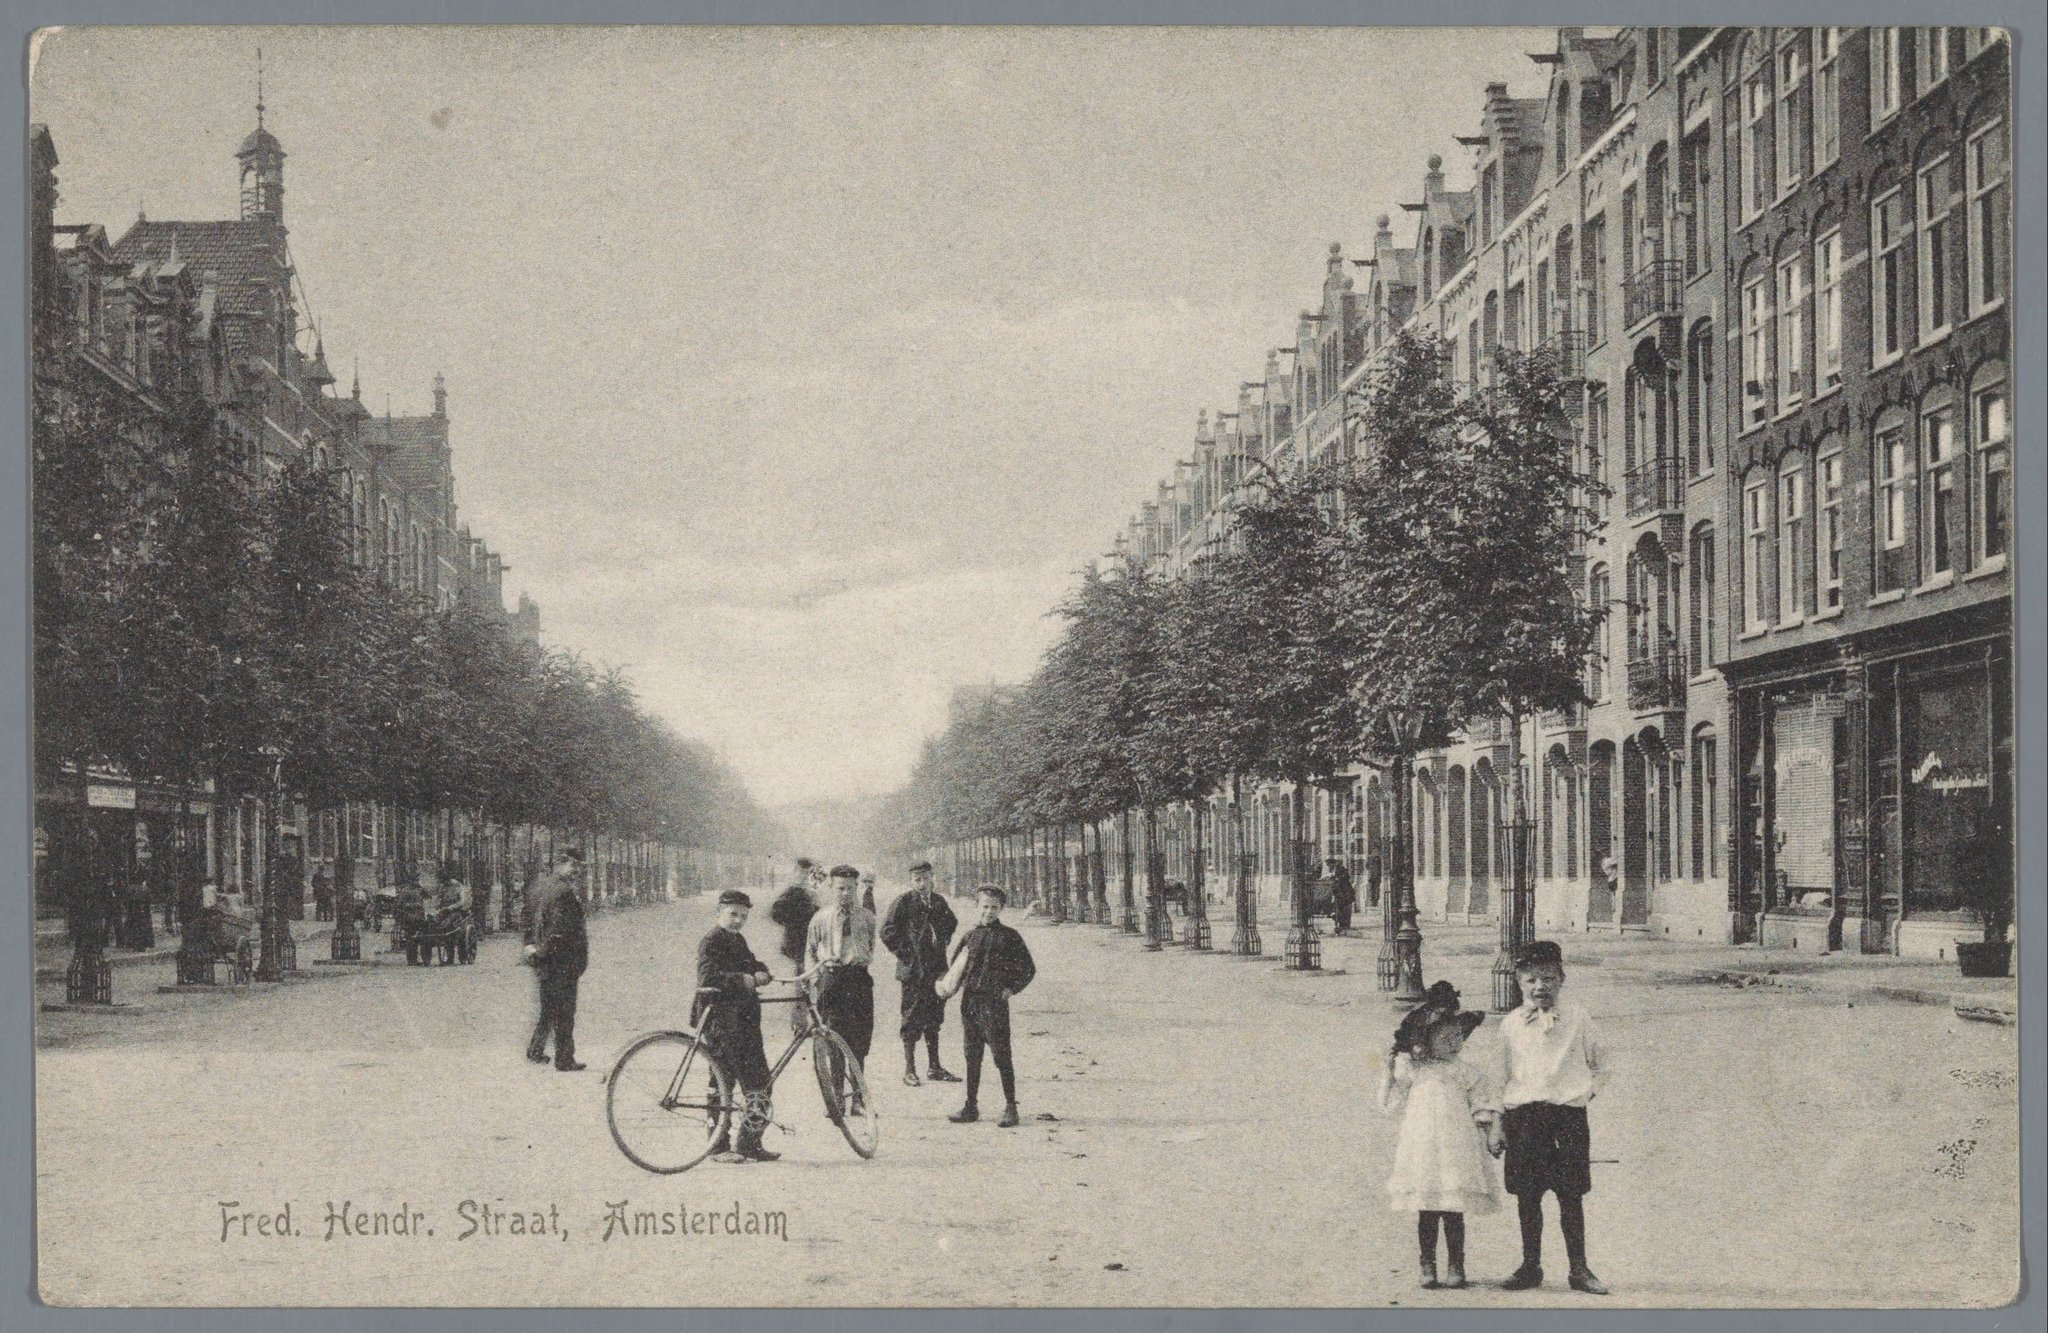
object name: photomechanical print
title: Fred. Hendr. Straat, Amsterdam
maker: h.g. schröder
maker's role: fotograaf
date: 1875-1930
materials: cardboard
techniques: photograph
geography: amsterdam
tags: street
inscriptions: inscription: ‘5882 Uitg. H. G. Schröder, Fred. Hendr. plantsoen 52, Amsterdam’